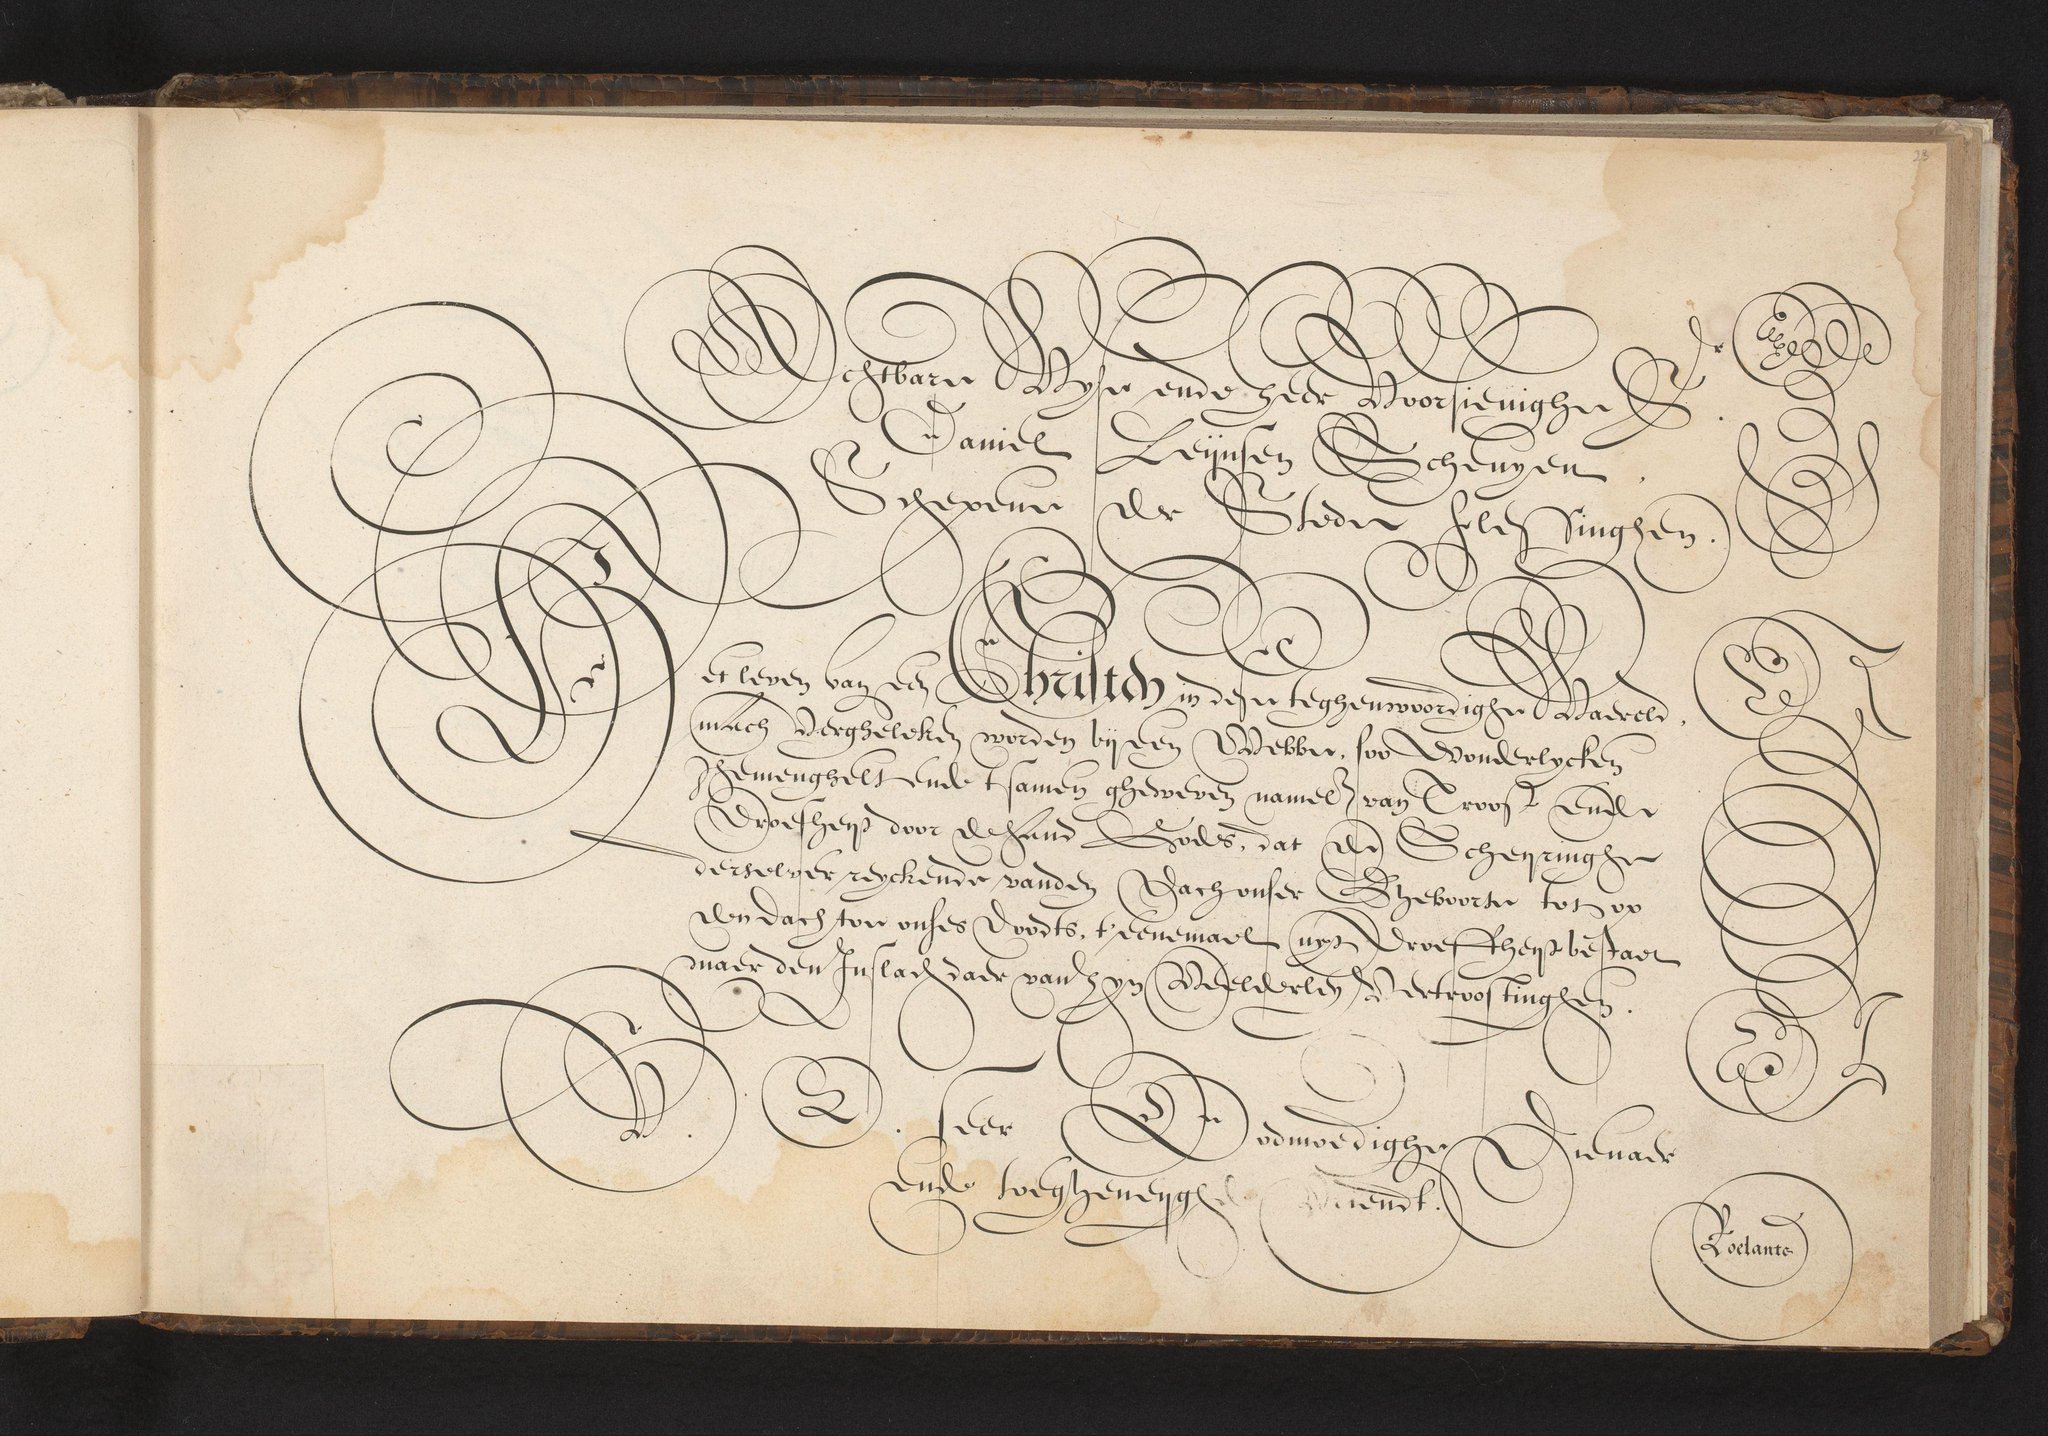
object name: print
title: 't Magazin oft pac-huys der loffelycker penn-const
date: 1616-1617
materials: paper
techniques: engraving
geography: flushing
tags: calligraphy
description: Schrijfvoorbeeld met grote initiaal H en zeven regels tekst in het Nederlands: Het leven van een Christen ... Daarboven een tweeregelige opdracht aan Daniel Leijnsen Scheuyen uit Vlissingen. Rechts van de tekst enkele figuren in krulwerk. De prent maakt deel uit van een album.